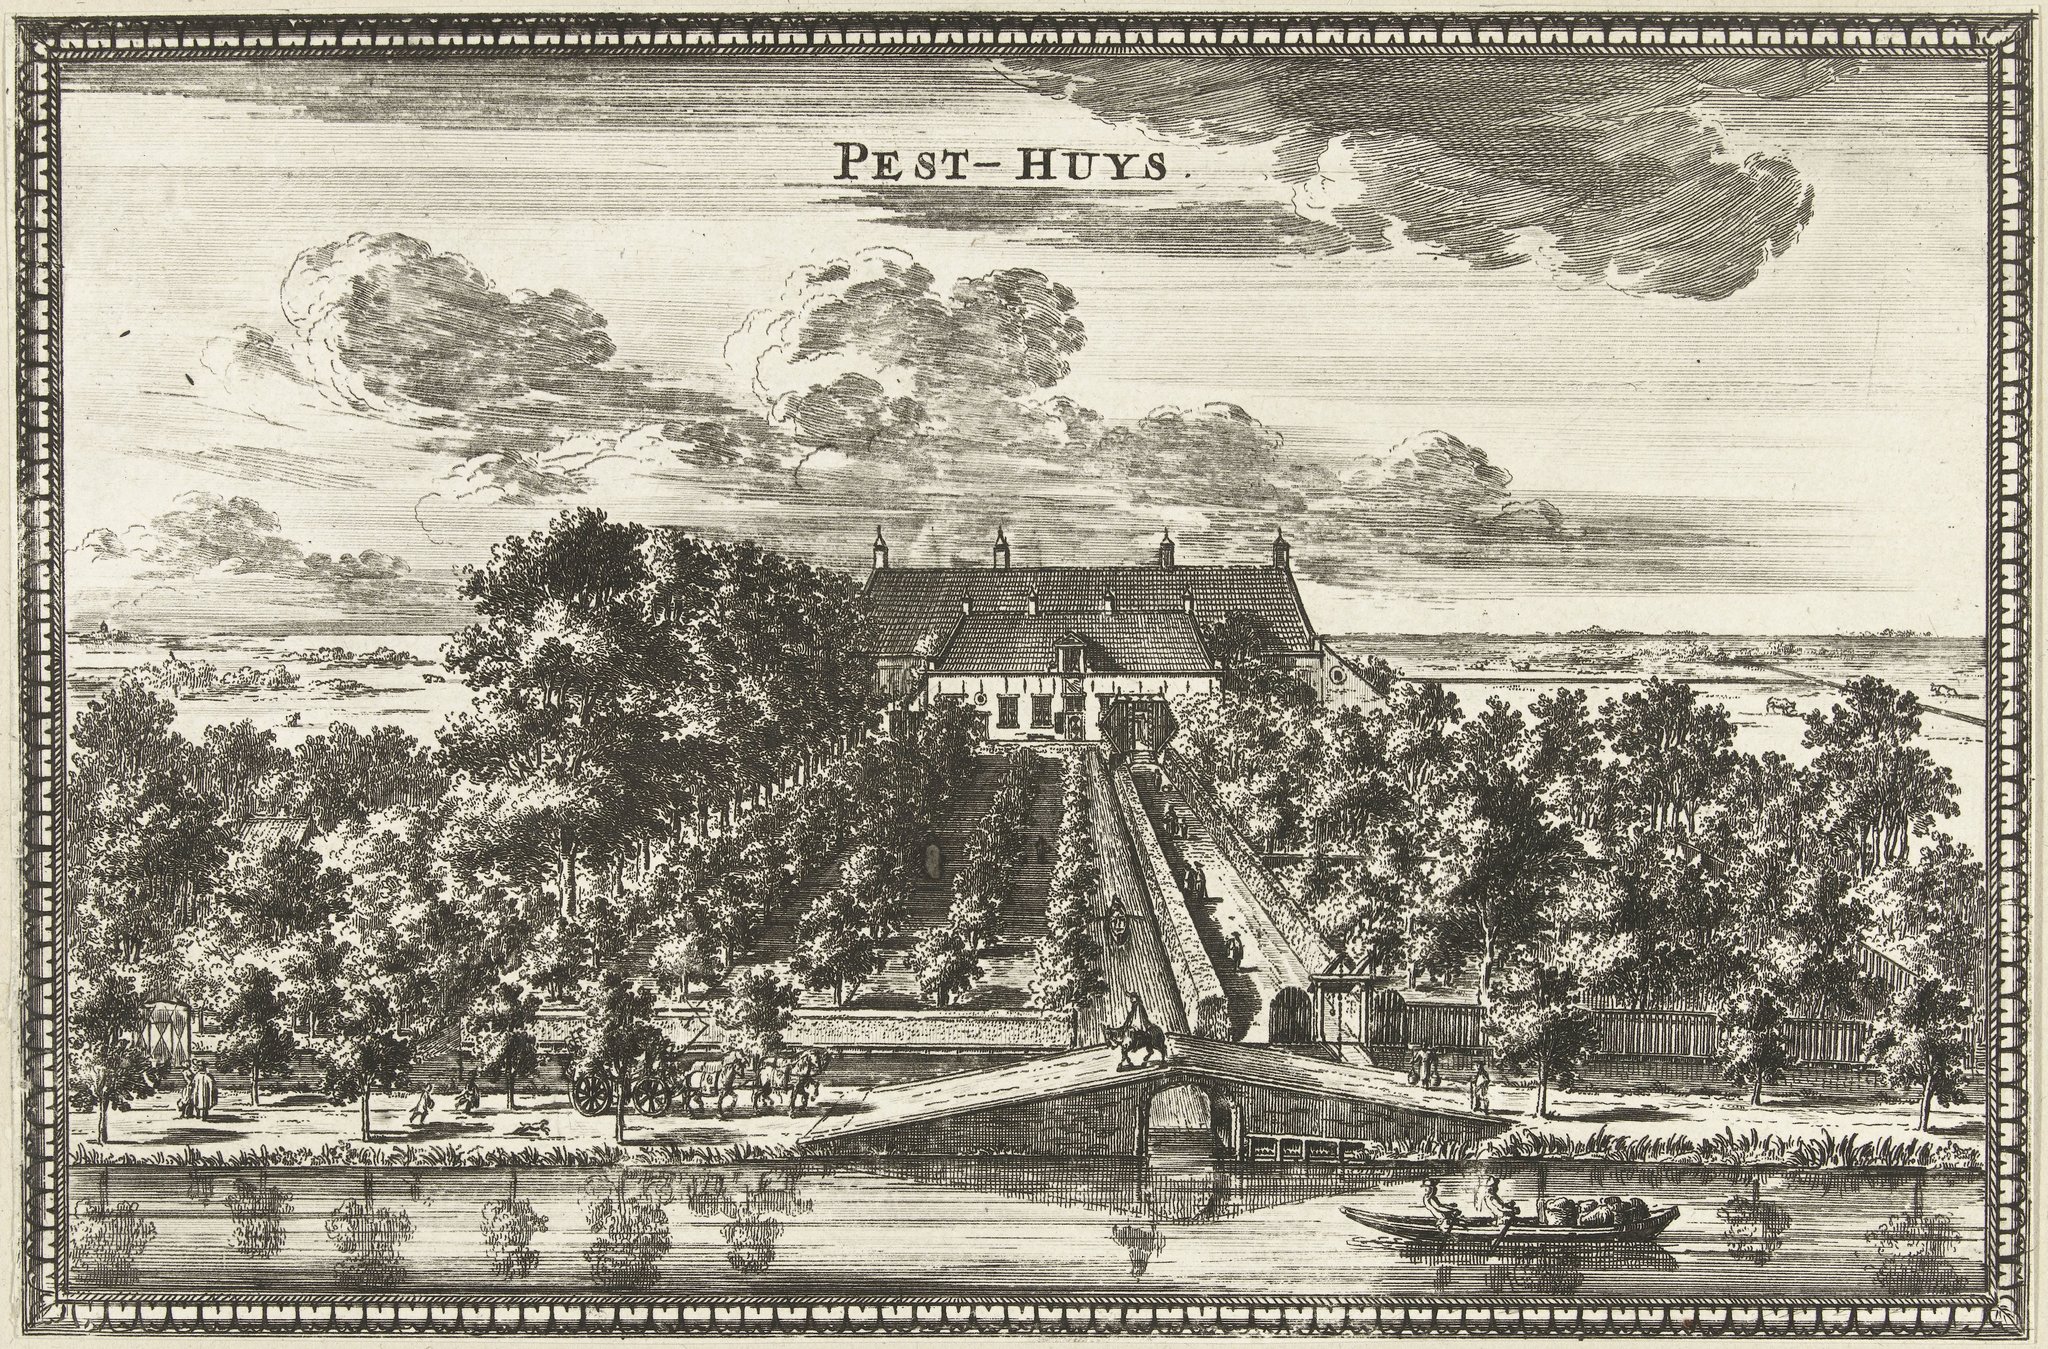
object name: print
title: Gezicht op het Pesthuis nabij Delft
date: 1678-1703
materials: paper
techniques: etching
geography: amsterdam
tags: hospital, delft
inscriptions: collector's mark: Lugt 2228, collector's mark: Lugt 195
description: Deze prent is in 1678 voor het eerst uitgegeven als onderdeel van de rand van de zogenaamde Kaart Figuratief (Caerte figuratyff / Kaerte figuratyf) van Delft, een wandkaart van Delft. Deze kaart bestaat uit een plattegrond van Delft (RP-P-AO-11-8A) met daaromheen een rand. De rand bestaat uit een profiel van Delft (RP-P-AO-11-11), een profiel van Delfshaven met daaronder de wapenschilden van de burgemeesters van de stad (RP-P-AO-13-51-1 en RP-P-AO-13-51-2), 24 kleinere prenten (kaarten, afbeeldingen van gebouwen en graven van bekende personen, o.a. huidige prent, RP-P-AO-11-15, RP-P-AO-11-16, RP-P-AO-11-17, RP-P-AO-11-18, RP-P-AO-11-19, RP-P-AO-11-20, RP-P-AO-11-21, RP-P-AO-11-23, RP-P-AO-11-24, RP-P-AO-11-27, RP-P-AO-11-28, RP-P-AO-11-29, RP-P-AO-11-31, RP-P-AO-11-33C, RP-P-AO-11-34, RP-P-AO-11-35, RP-P-AO-11-35-2, RP-P-AO-13-49, RP-P-AO-13-52, RP-P-AO-13-53, RP-P-AO-13-54-1 en RP-P-1909-6463) en een beschrijving van de stad (RP-P-AO-11-8E). De eerste druk van deze Kaart Figuratief (1678) werd, in opdracht van het Delftse stadsbestuur, verzorgd door Pieter Smith. In 1680 leverde Smith ook vijfhonderd afdrukken van de randprenten die bestemd waren voor Dirk Evertsz. Bleyswijcks 'Beschryvinge der stadt Delft' (1667) en het tweede deel: 'Vervolg van de beschryvinge der stadt Delft' (1680). In het tweede deel zat een bijlage waarin beschreven staat welke prenten waar in het eerste en tweede deel ingebonden dienden te worden. Een deel van de prenten was dus bestemd voor het in 1667 verschenen eerste deel en kon met het verschijnen van het tweede deel in 1680 alsnog worden ingebonden. Hierdoor wordt vaak gedacht dat de prenten uit het eerste deel dateren uit 1667, hetgeen niet klopt. De huidige prent is zodoende ook gebruikt in: Bleyswijck, Dirk Evertsz. Vervolg van de beschryvinge der stadt Delft, met een generael register over beyde stucken voorsien. Delft: Arnold Bon, 1680, p. 501. Pieter Mortier (I) verzorgde in 1703, tevens in opdracht van het stadsbestuur, een tweede uitgave van de Kaart Figuratief. Voor deze druk bracht graveur Thomas van der Wilt enkele aanpassingen aan op de platen van de plattegrond. De randplaten lijken, op de plaat met de wapens van de burgemeesters na, ongewijzigd te zijn gebleven. De plattegrond is in 1752, waarschijnlijk zonder de randprenten, opnieuw uitgegeven. Een deel van de randprenten, waaronder de huidige prent, is in 1729 opnieuw gebruikt in: Beschryving der stadt Delft, behelzende een zeer naaukeurige en uitvoerige verhandeling van deszelfs eerste oorsprong (…). Delft: Reinier Boitet, 1729. Op twee na (die van de Nieuwe en Oude Kerk) paste Boitet de platen aan, waardoor van deze prenten een tweede staat ontstond. Of de huidige prent is gebruikt als onderdeel van de rand van de Kaart Figuratief uit 1678 of 1703, of is gebruikt in 'Vervolg van de beschryvinge der stadt Delft' (1680), is niet na te gaan.